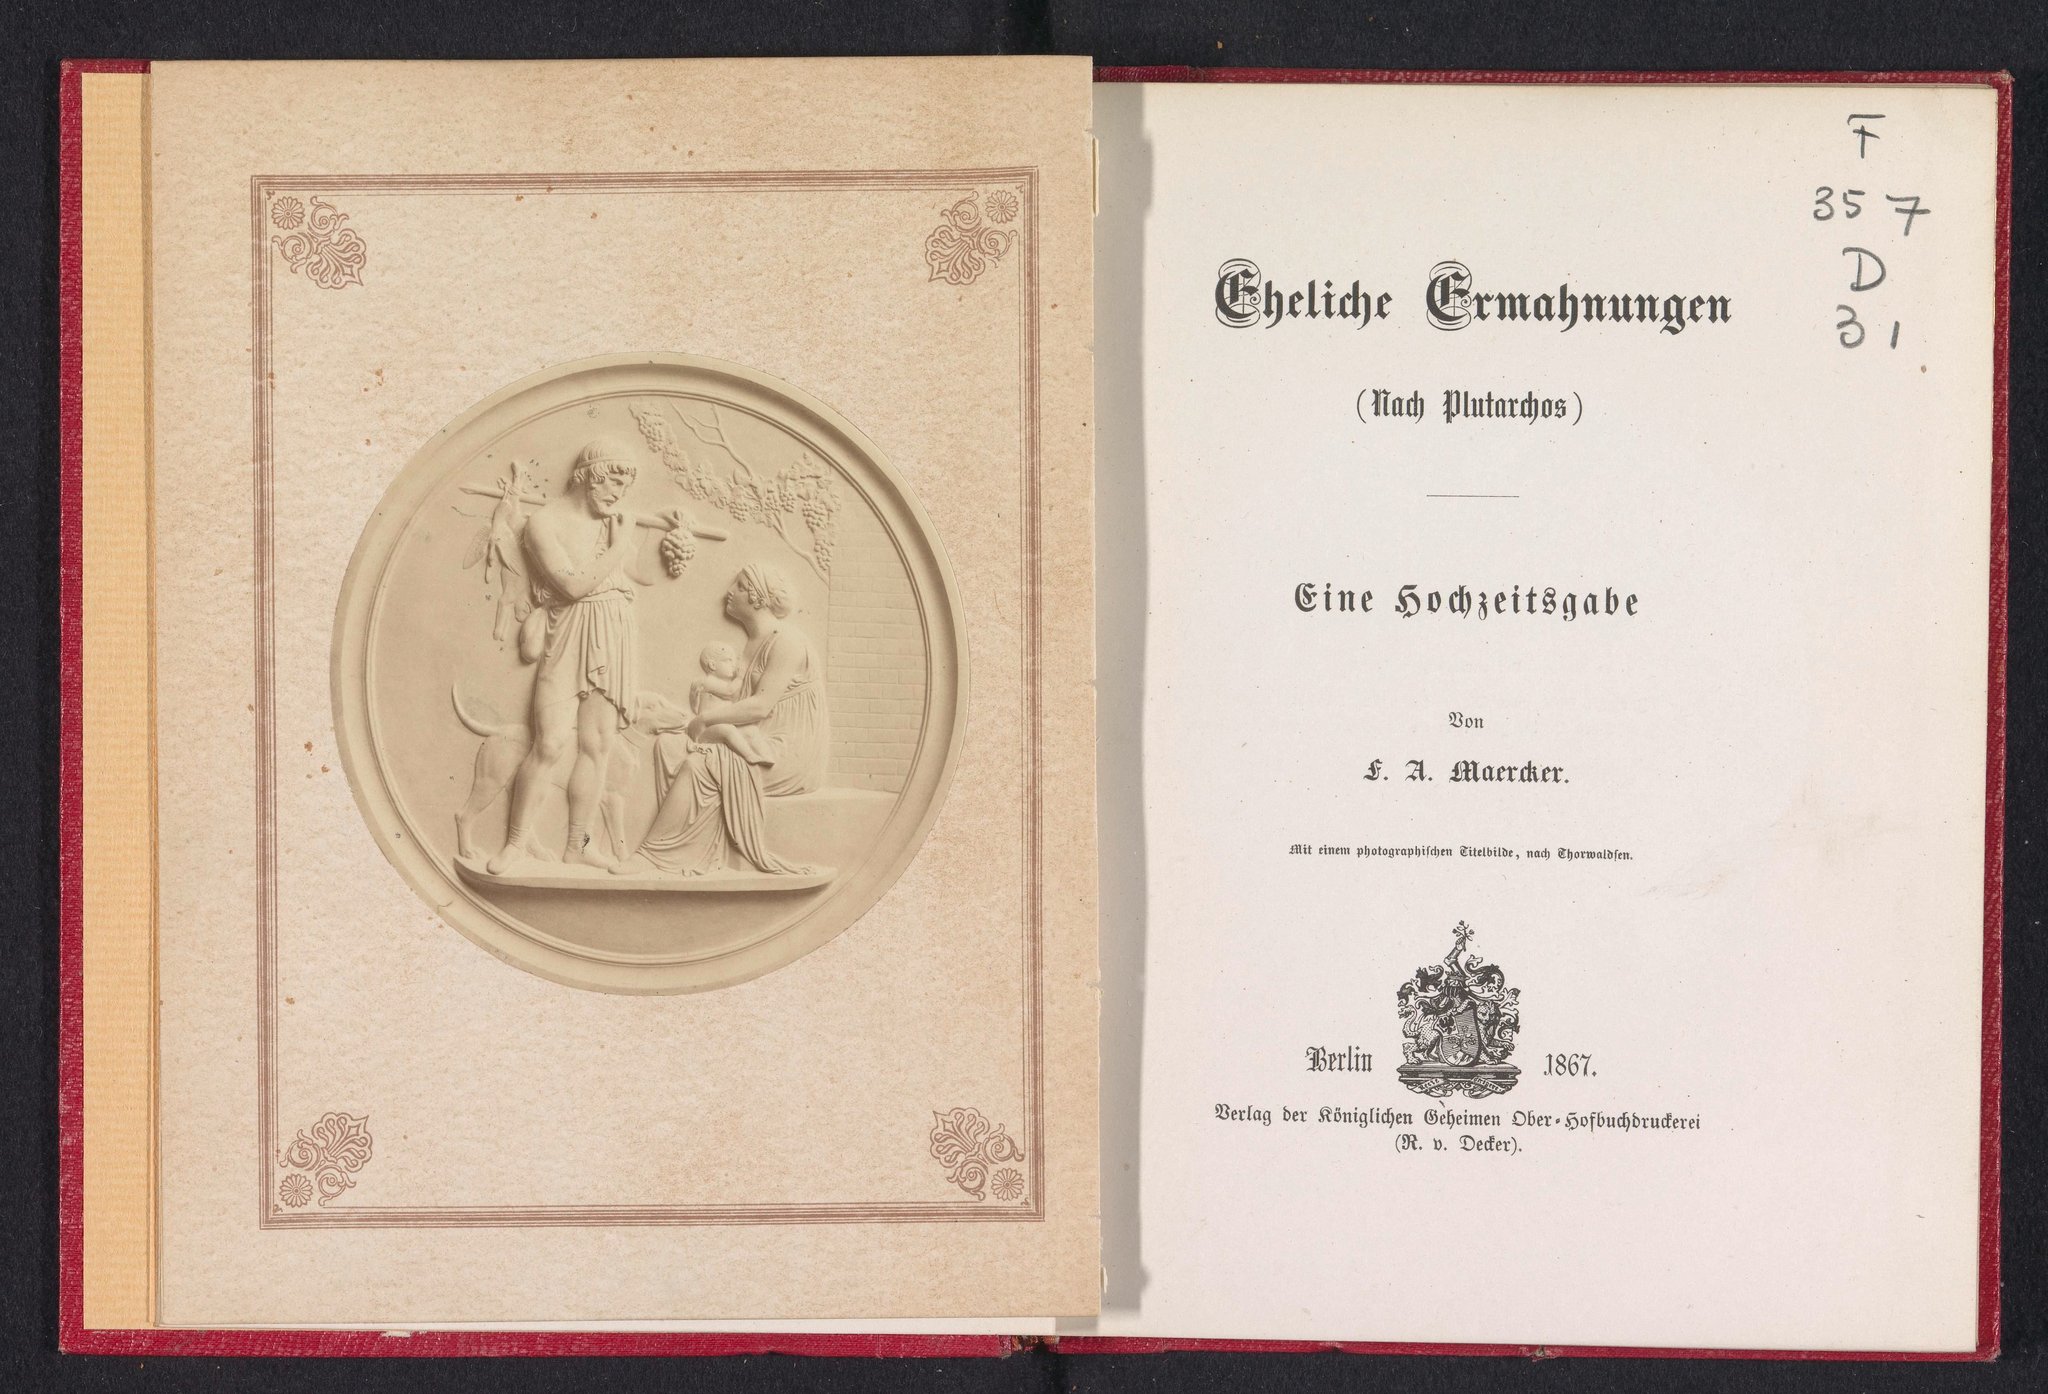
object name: page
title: Reliëf, voorstellende een jager naast een vrouw met een kind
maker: Anonymous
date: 1862-1867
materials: photographic support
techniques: albumen print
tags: hunter, mother and baby or young child